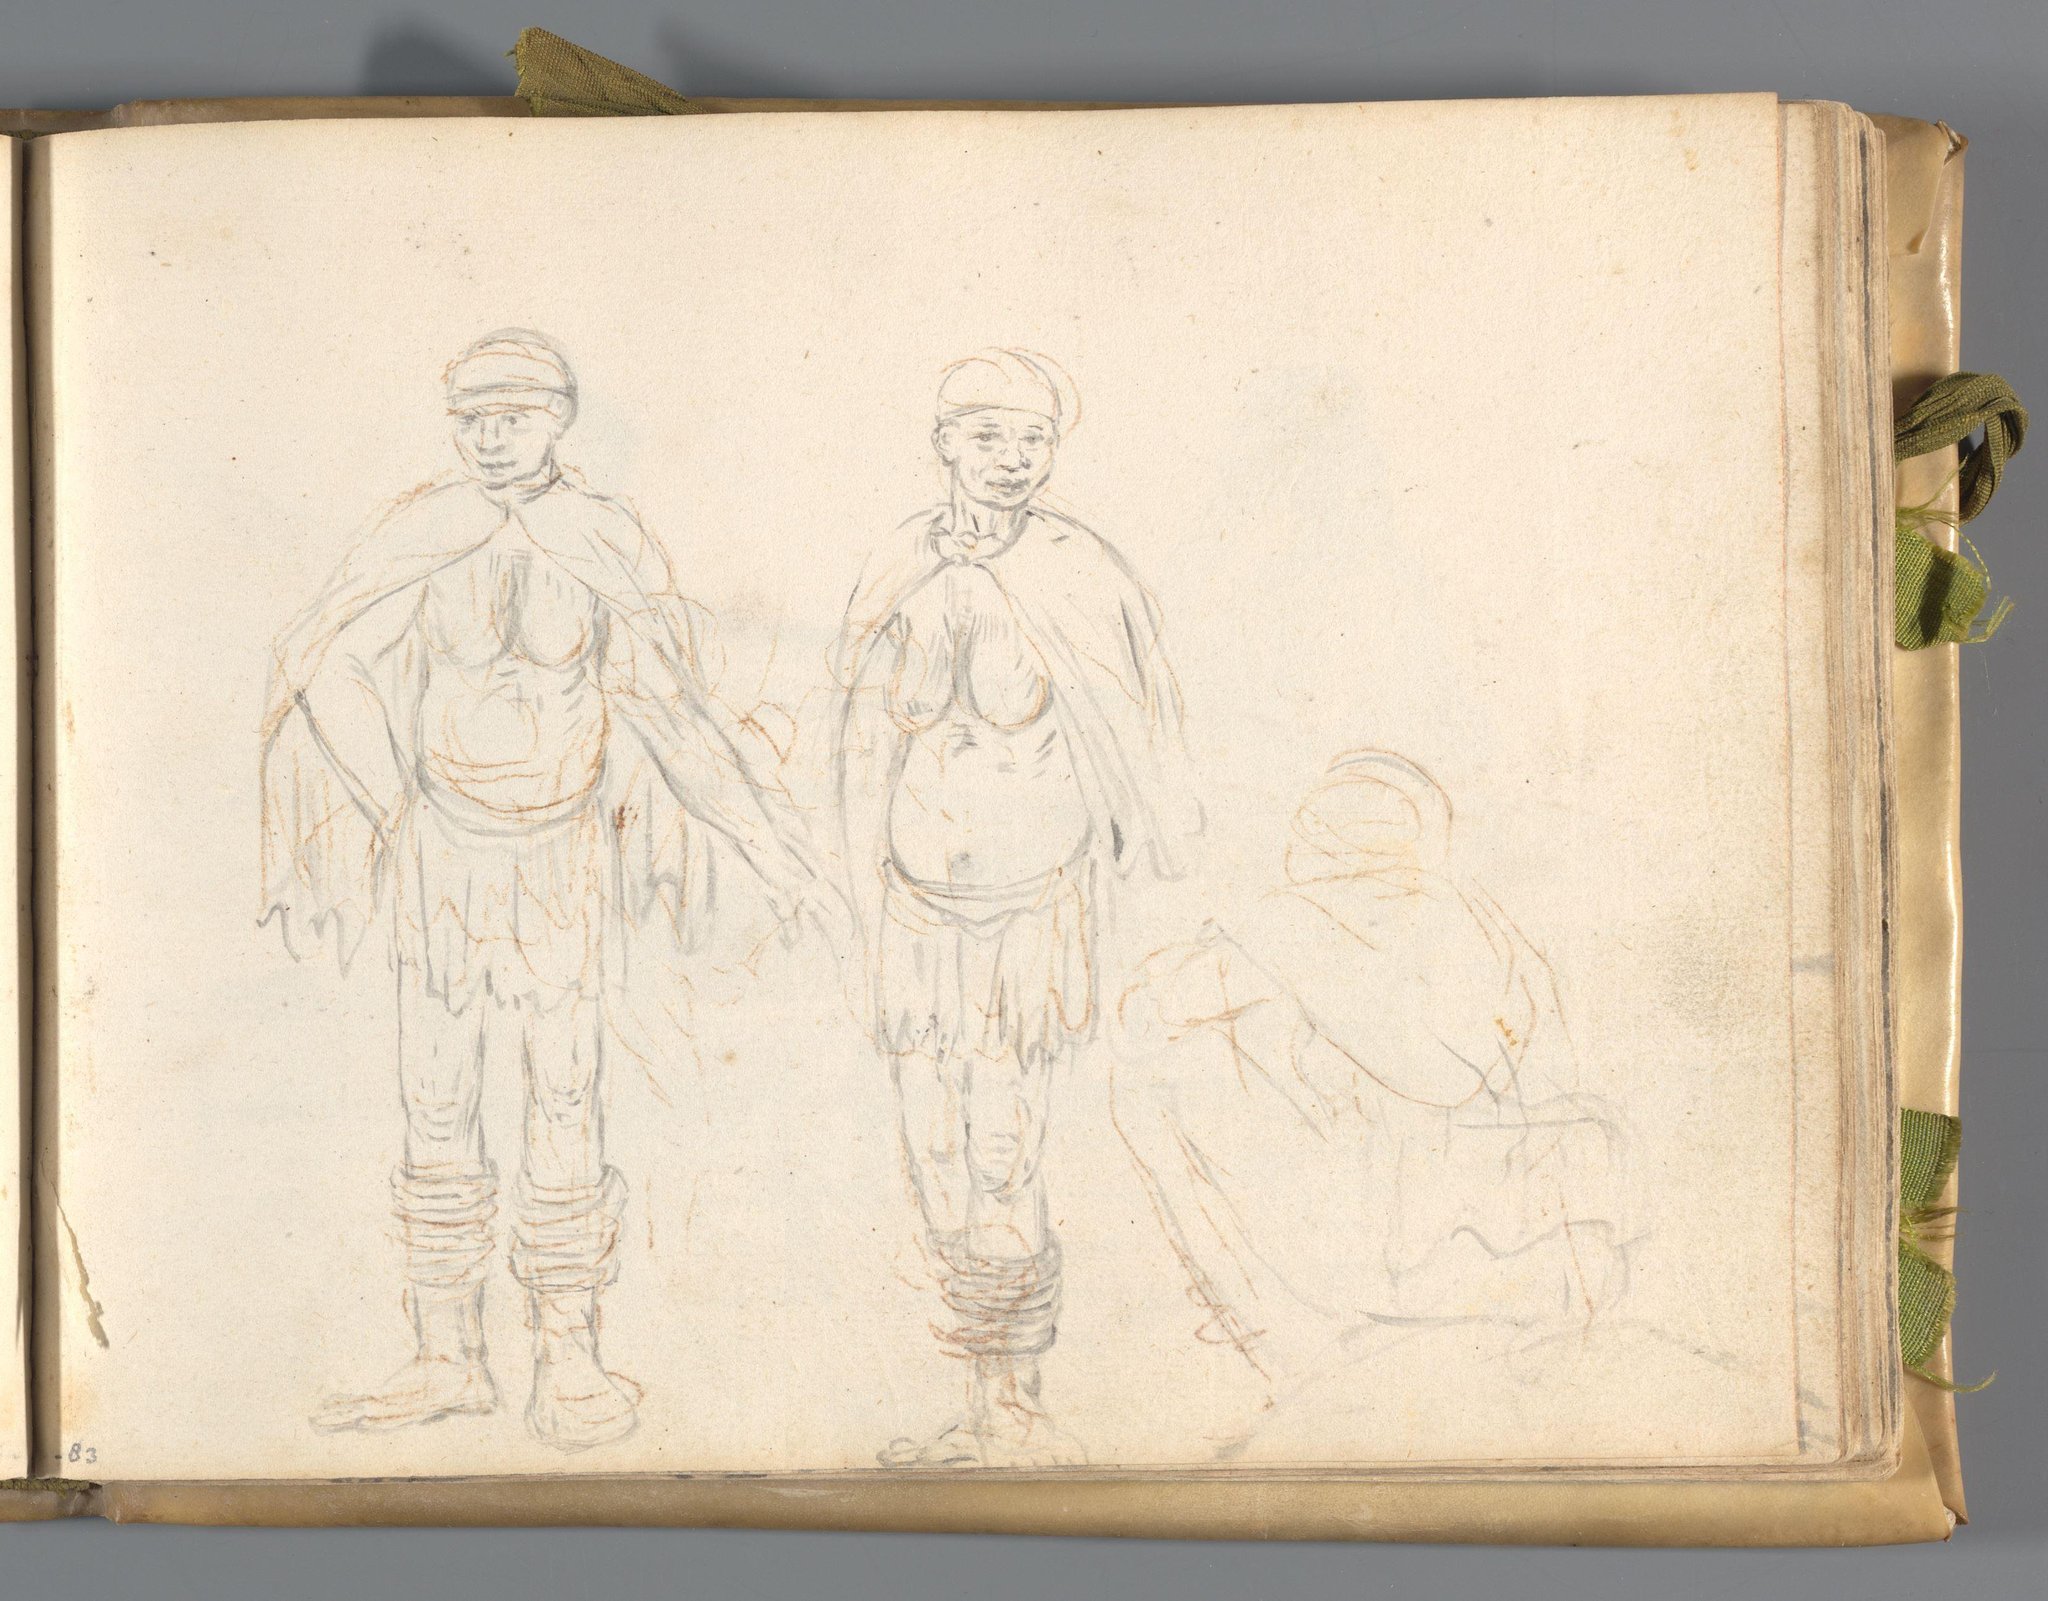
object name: sketchbook leaf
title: Three South African Khoisan women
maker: esaias boursse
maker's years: 1631-1672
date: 1662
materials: chalk, ink, paper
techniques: brush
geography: cape of good hope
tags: african peoples (khoisan), cape of good hope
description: Een onafgemaakte schets van drie vrouwen in een onduidelijke omgeving, waarschijnlijk buiten. Aan hun uiterlijk en kleding zijn ze te herkennen als leden van de Khoisan in zuidelijk Afrika. De twee staande vrouwen dragen een kort rokje van niet herkenbaar materiaal en een bij de hals dichtgemaakte schoudermantel. Het bovenlichaam, armen en benen zijn ontbloot. Om de kuiten dragen beide vrouwen beenversieringen, mogelijkerwijs van omgewonden pezen of ander materiaal. Het hoofd is tot op de oren bedekt met een muts of een hoofdband. De hurkende vrouw geheel rechts is zeer vaag van achteren geschetst. Blad 83 uit een schetsboek met 117 bladen.